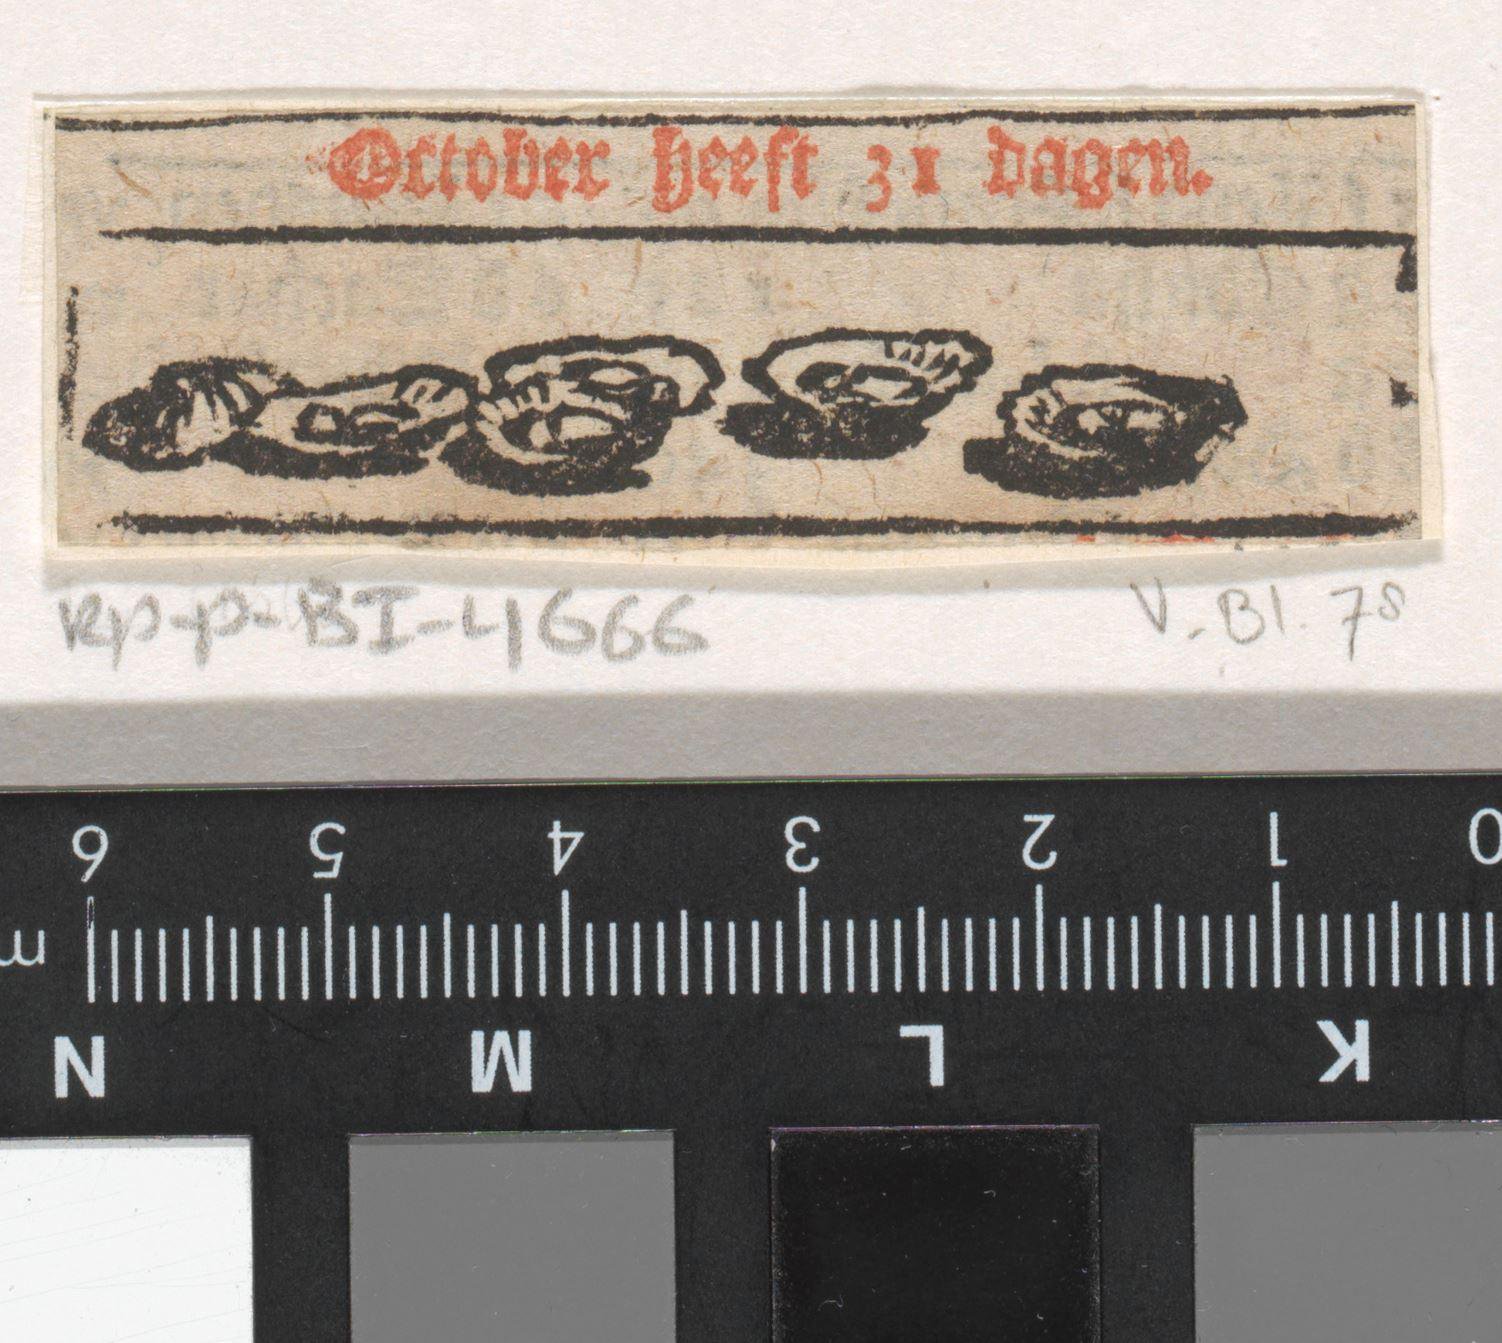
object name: print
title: Maanden van het jaar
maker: dirck de bray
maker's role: draughtsman, painter, print maker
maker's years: 1625-1694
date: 1672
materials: paper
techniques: letterpress printing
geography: netherlands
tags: october ~ other concepts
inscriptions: collector's mark: Lugt 2228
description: Een aantal oesters. In de bovenmarge een regel Nederlandse tekst.